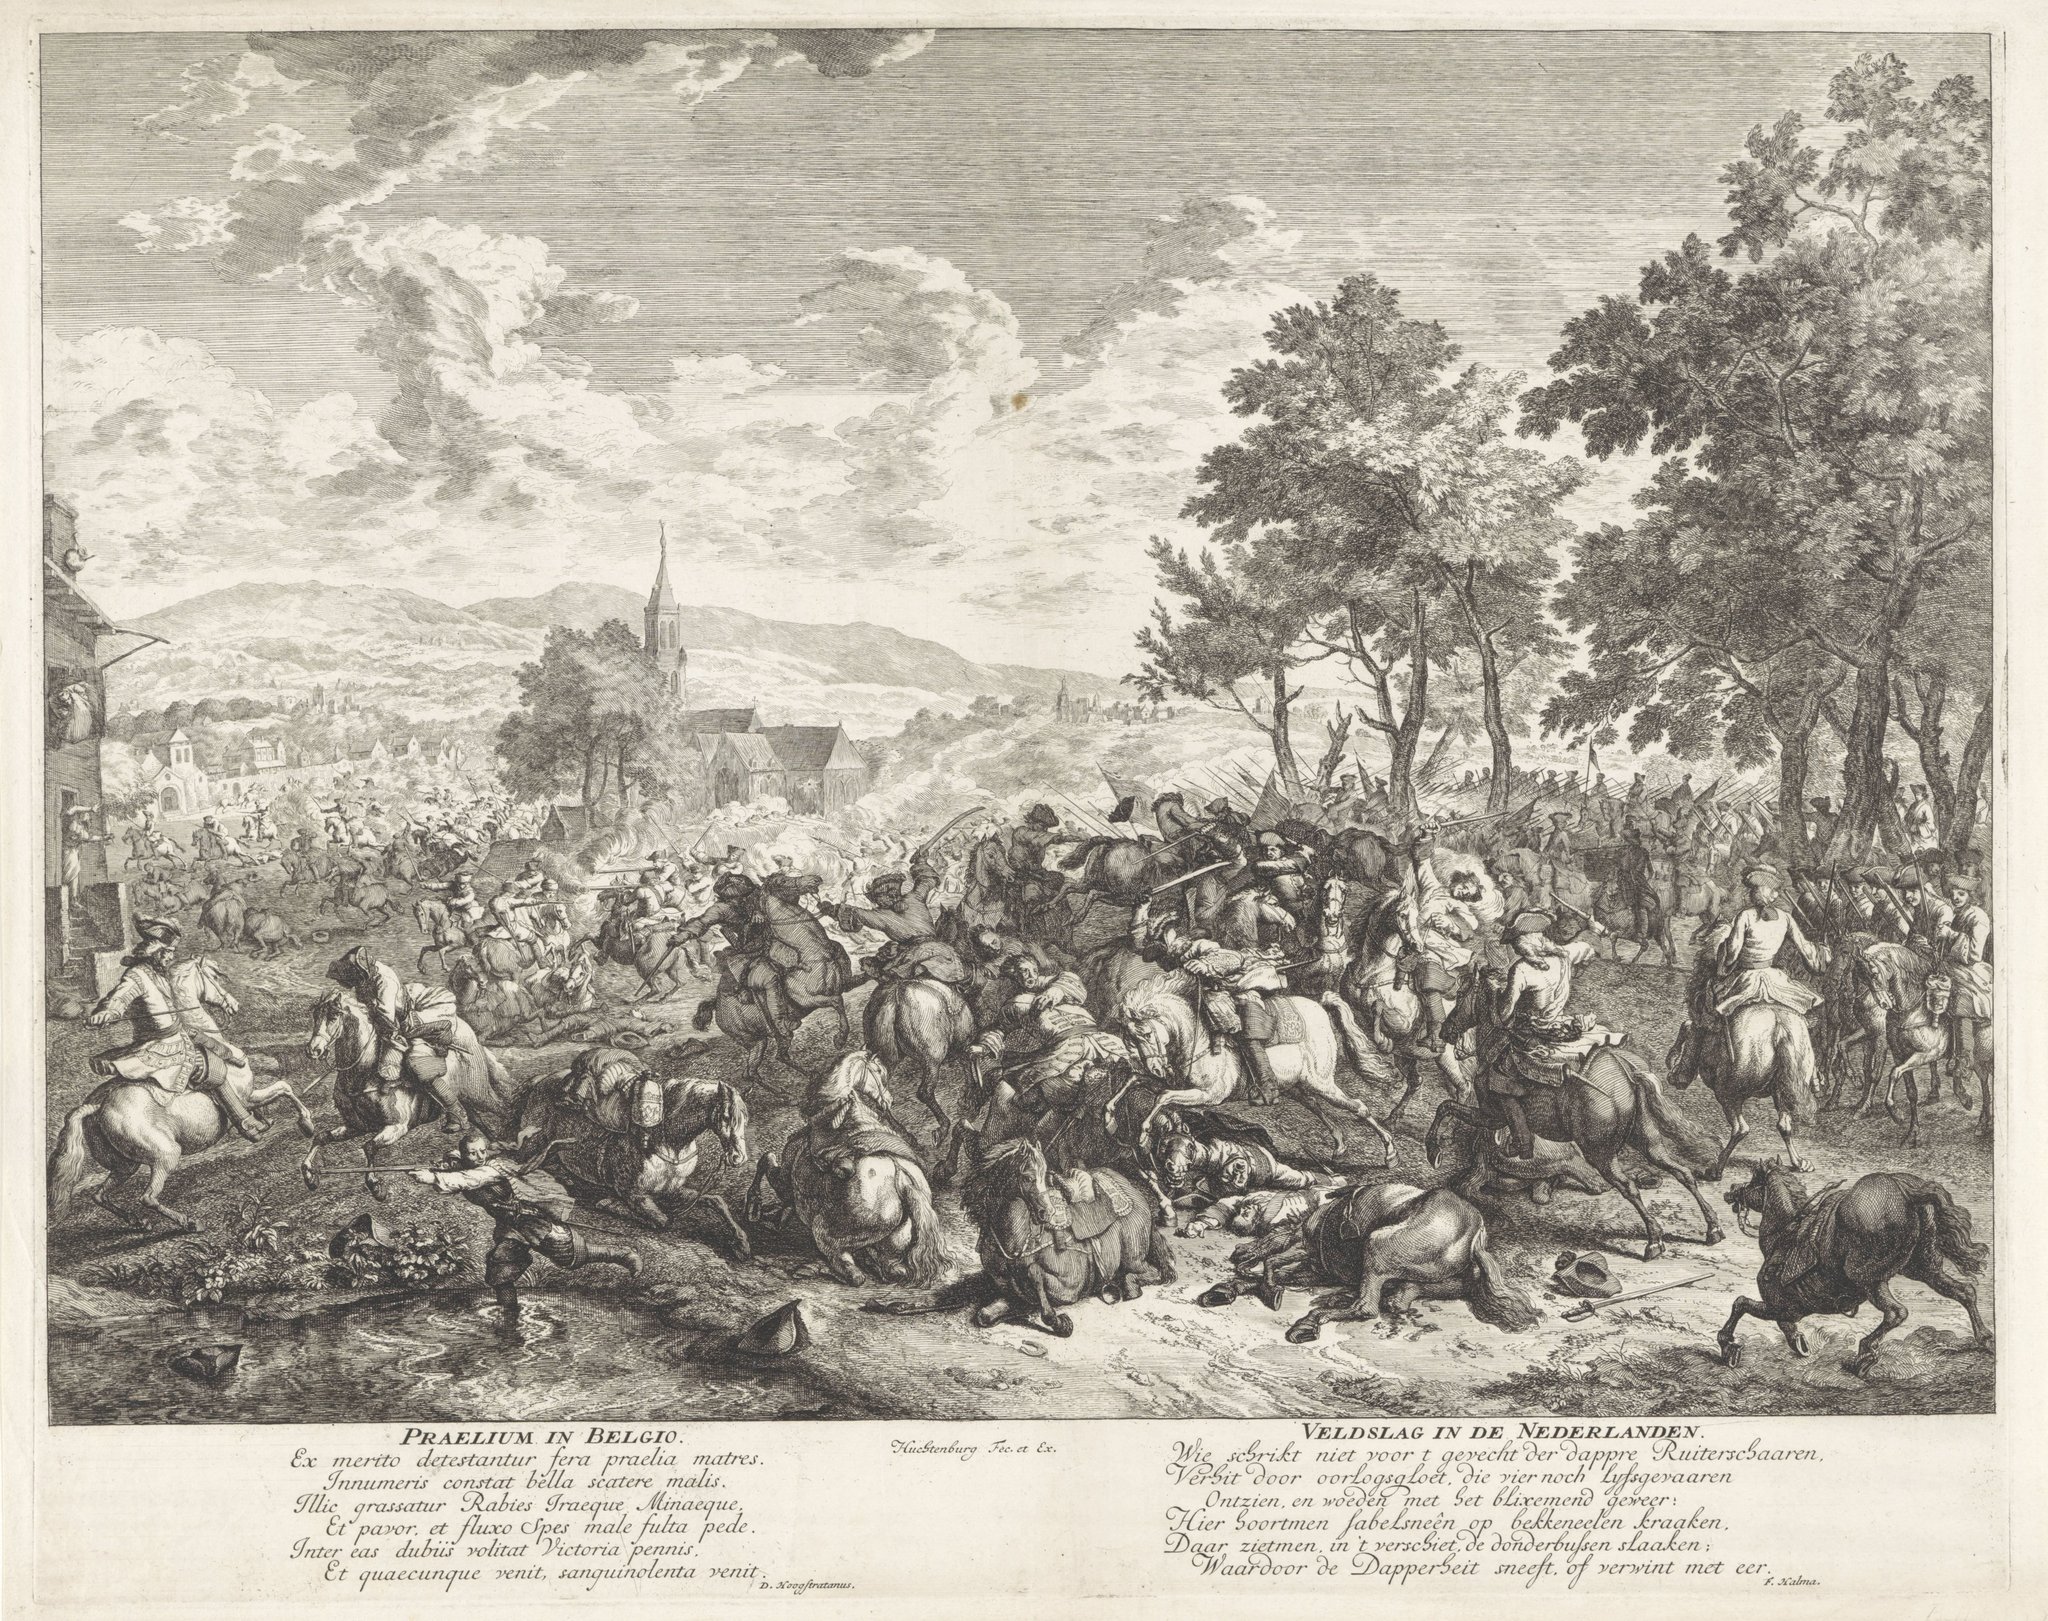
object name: print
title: Praelium in Belgio / Veldslag in de Nederlanden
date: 1701-1703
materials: paper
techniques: etching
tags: battle (+ cavalry, horsemen)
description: Gezicht op een woest ruitergevecht in de Nederlanden, ten tijde van de Spaanse Successieoorlog, ca. 1702. Op de achtergrond een kerk. Onderaan in de marge een zesregelige tekst in het Latijn en een zesregelige tekst in het Nerderlands.